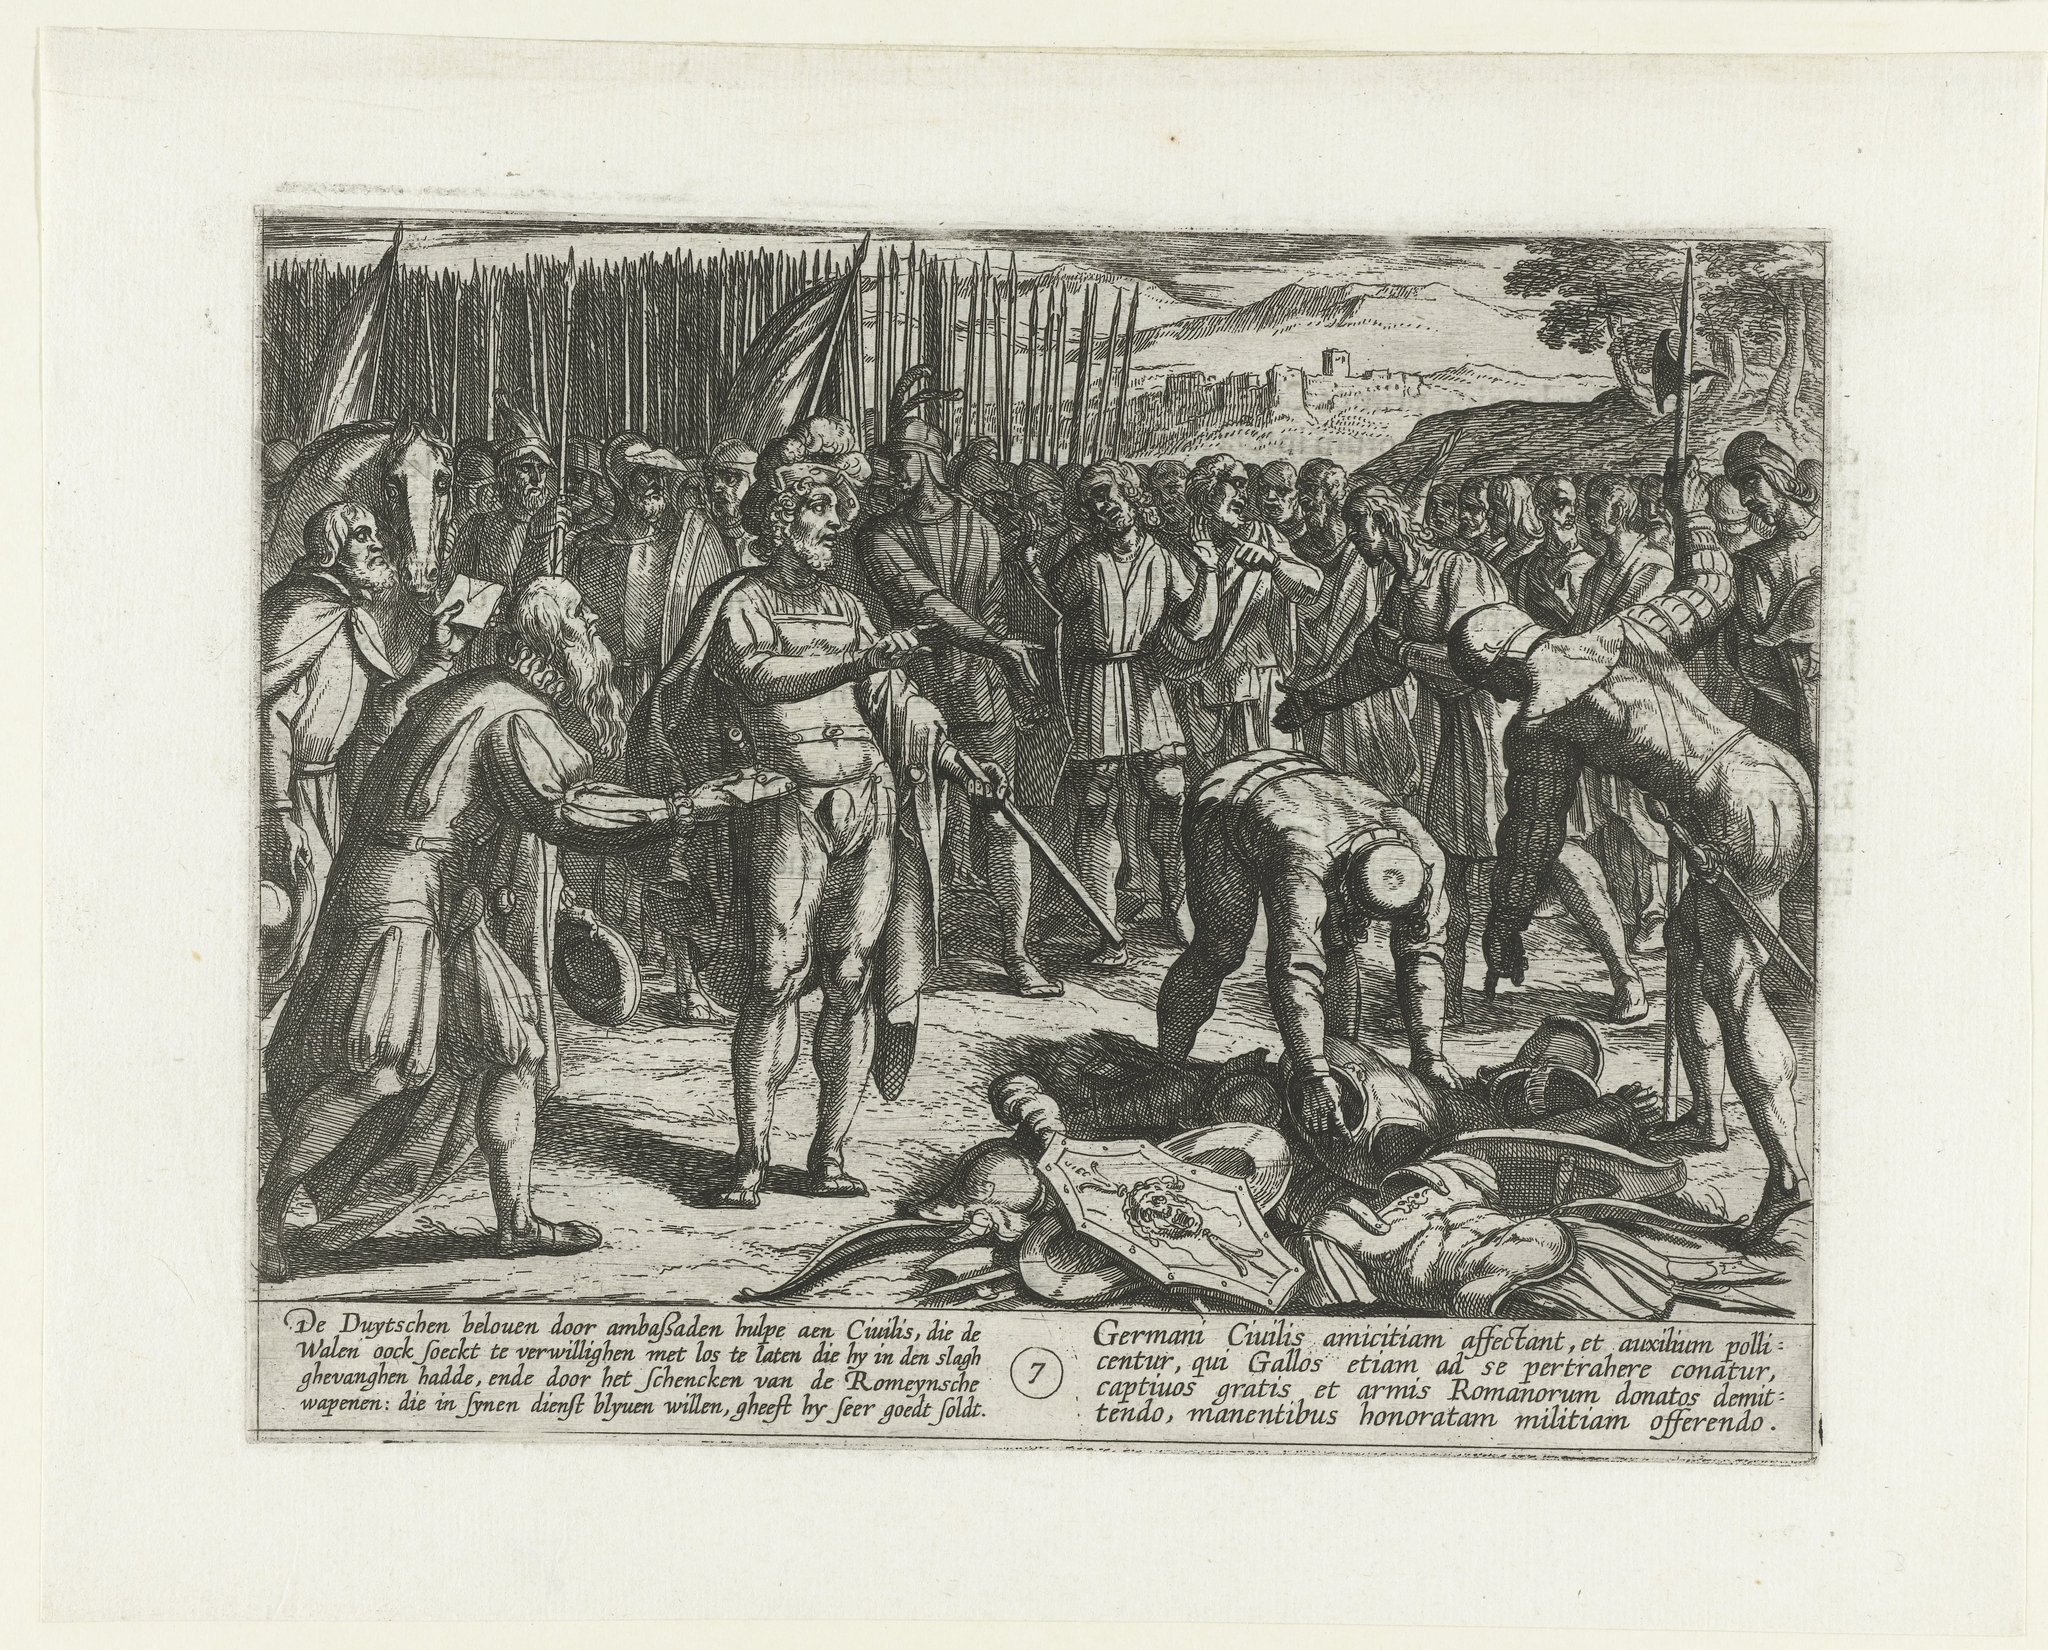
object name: history print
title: De Bataafse Opstand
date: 1612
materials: paper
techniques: etching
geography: italy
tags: extinct, 'historical' peoples (with name), netherlands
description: De Germaanse ambassadeur bezoekt Civilis en belooft steun. Prent nummer 7 in de serie prenten over de Bataafse Opstand: Batavorum cum Romanis bellum / à Corn. Tacito lib. IV & V. : Hist. olim descriptum, figuris nunc aeneis expressum, auctore Othone Vaenio Lugdunobatava = De Batavische oft oude Hollandtsche oorloghe teghen de Romeynen. Otto Vaenius, Antwerpen 1612. Onderaan twee verzen van vier regels in het Nederlands en in het Latijn. Op de achterzijde tekst in het Latijn.